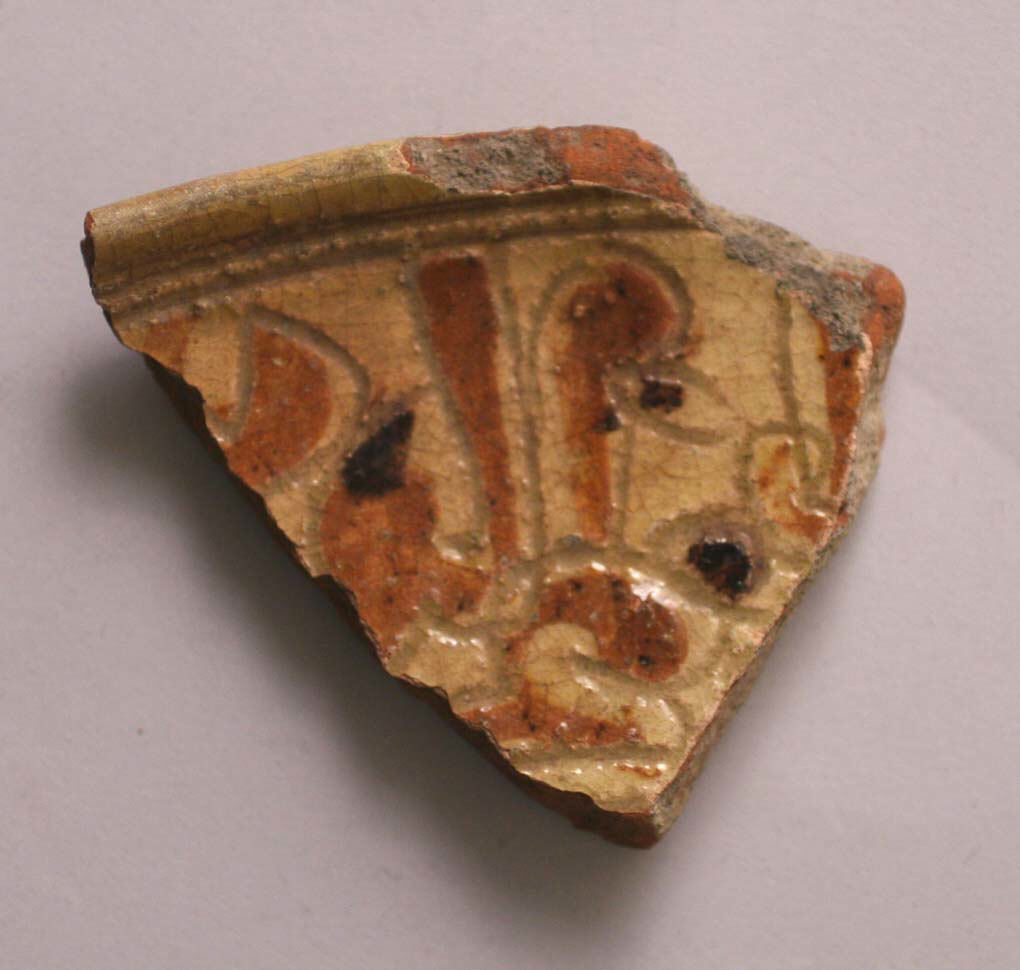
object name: fragment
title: Ceramic Fragment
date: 1301-1500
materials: earthenware, glaze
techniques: coloring, incising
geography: egypt